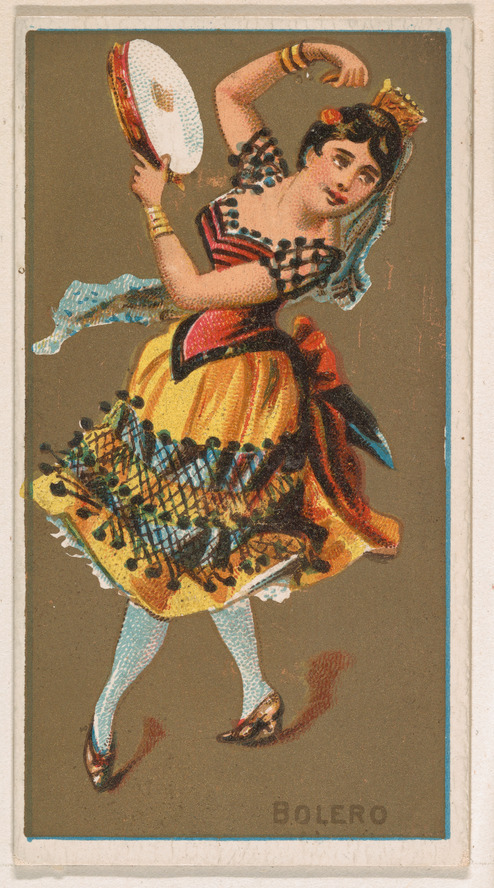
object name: print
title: Bolero, from National Dances (N225, Type 1) issued by Kinney Bros.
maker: kinney brothers tobacco company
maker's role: publisher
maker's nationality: american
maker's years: 1869-2011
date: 1889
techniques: color lithograph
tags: women,dancing